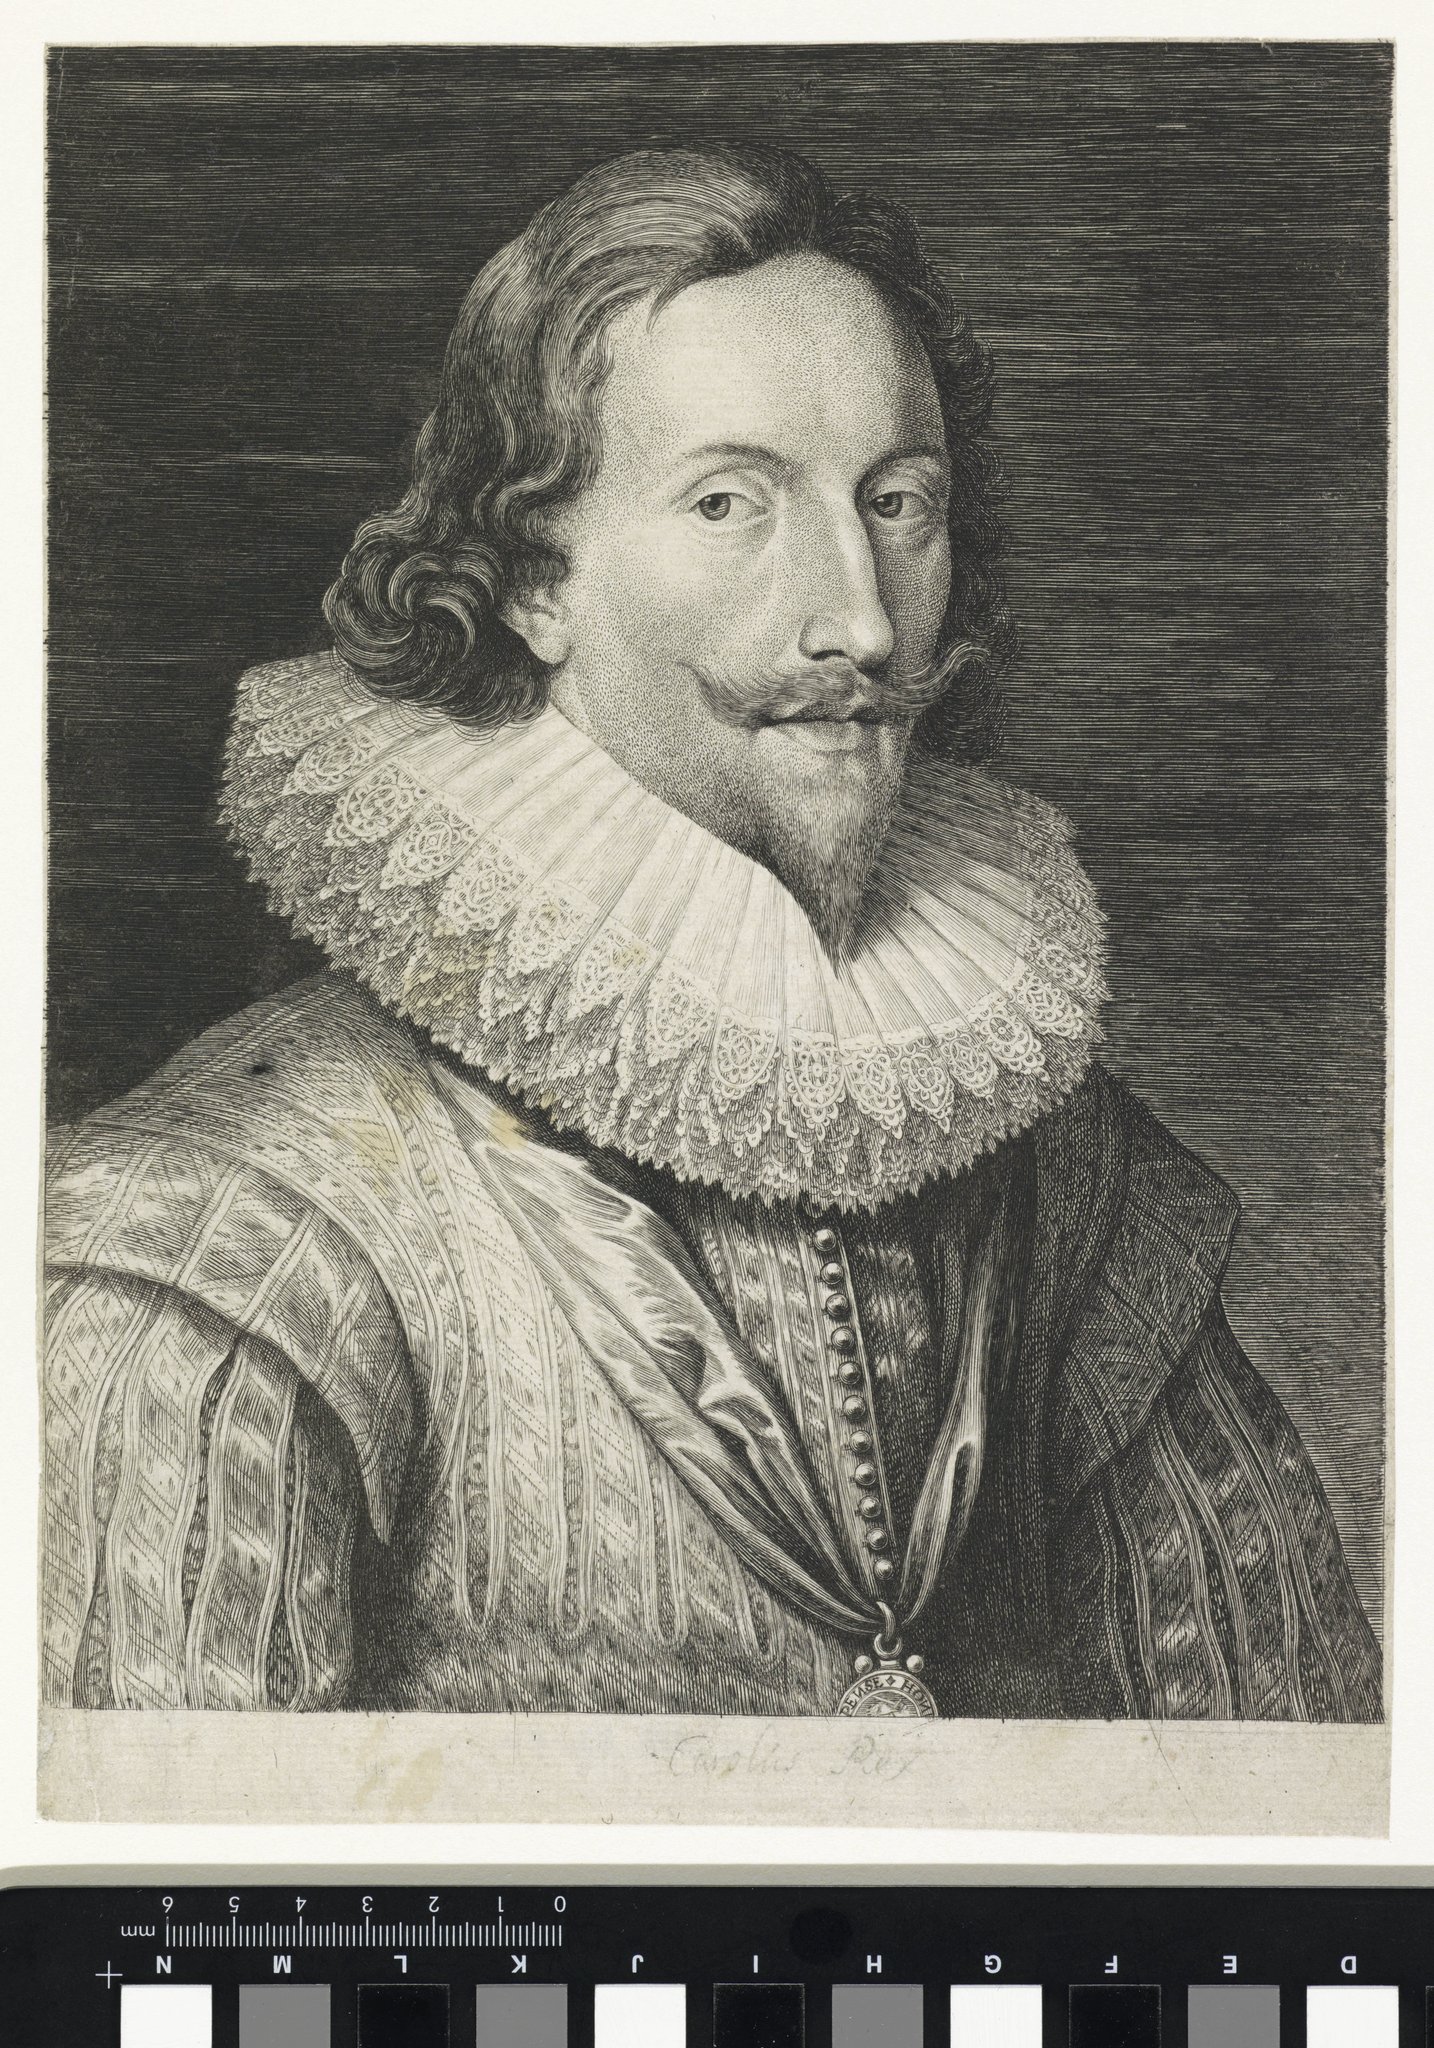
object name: print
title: Portret van Karel I, koning van Engeland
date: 1625-1642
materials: paper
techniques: engraving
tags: karel i (koning van engeland)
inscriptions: collector's mark: Lugt 240